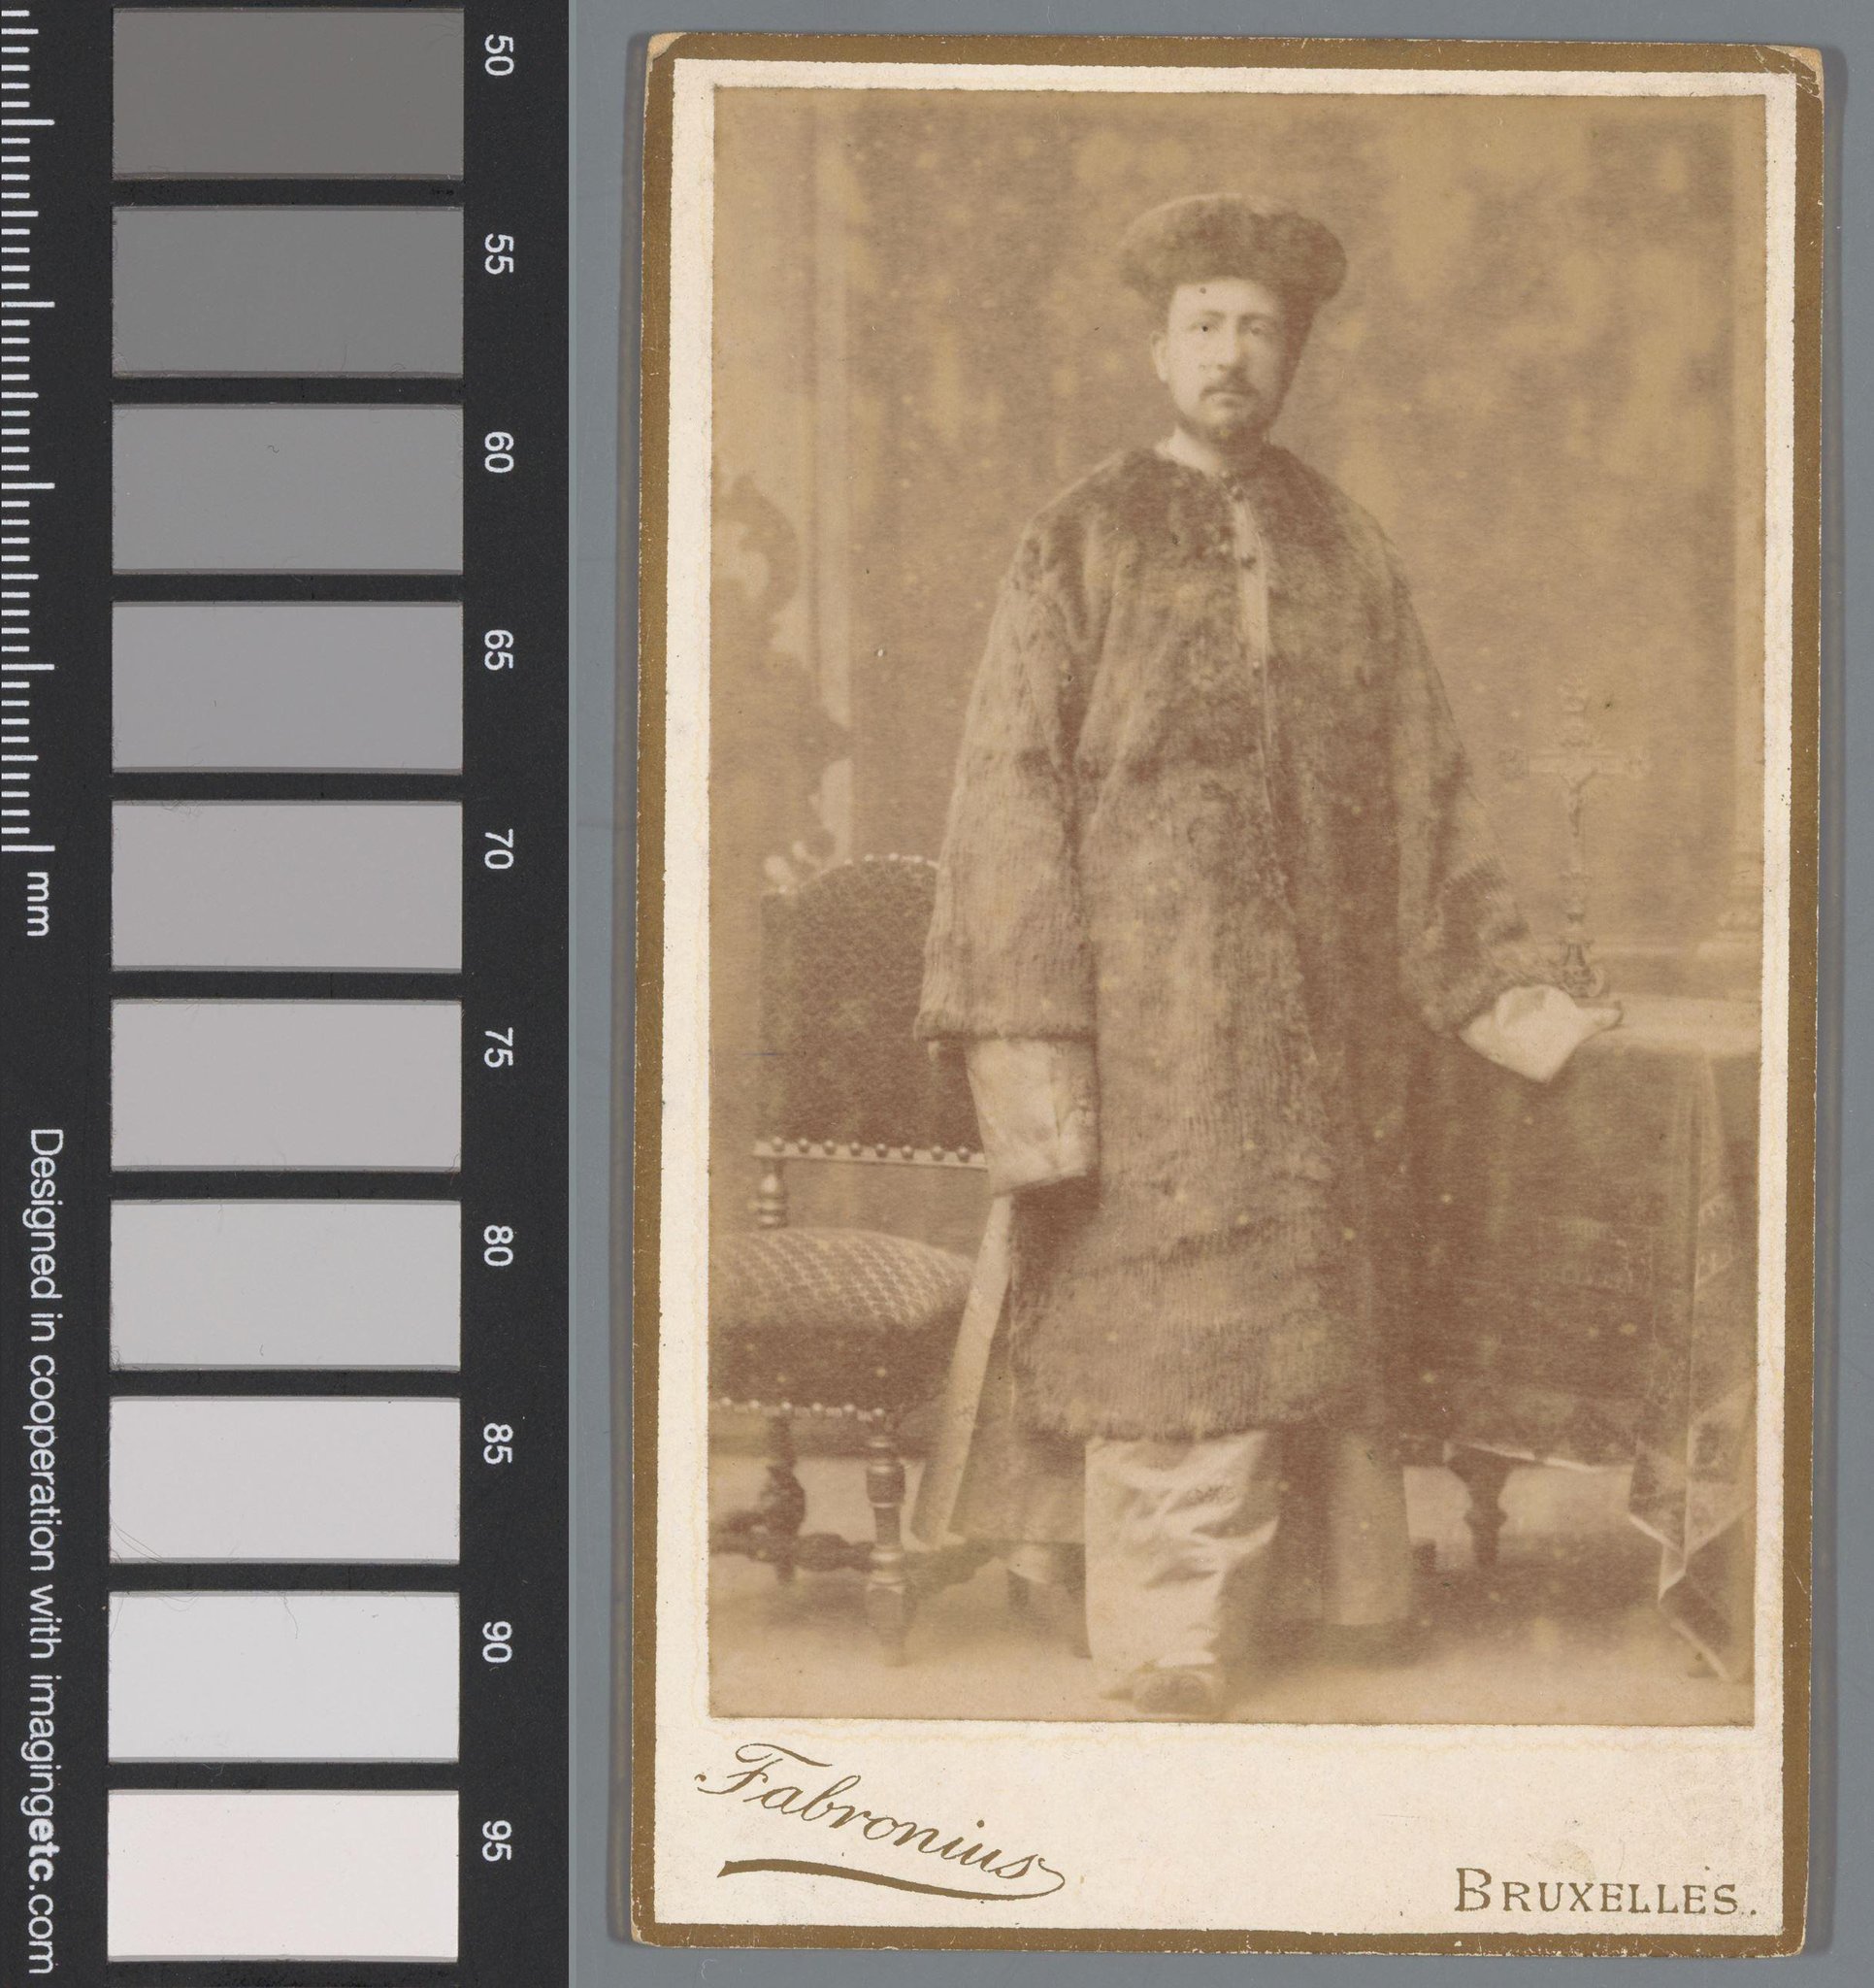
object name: carte de visite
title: Portret van een onbekende man in een toga of bontjas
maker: edouard fabronius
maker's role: fotograaf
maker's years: 1847-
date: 1882-1891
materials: cardboard, paper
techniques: albumen print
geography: brussels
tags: adult man, anonymous historical person portrayed, coat, cape, brussels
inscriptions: inscription: ‘Fabronius Bruxelles.’, inscription: ‘Fabronius/ Photographie/ 9 rue neuve/ Bruxelles./ Les clichés sont conservés.’